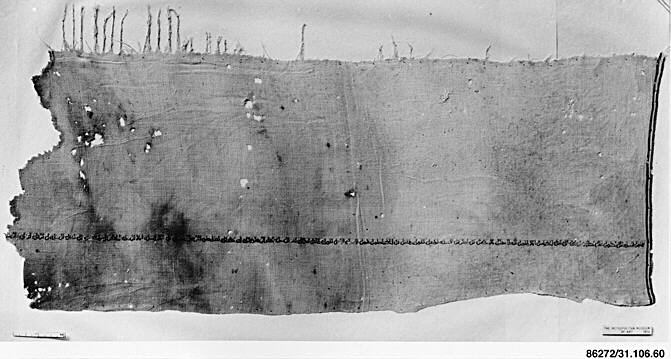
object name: textile fragment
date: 1001-1100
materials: linen, silk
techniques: weave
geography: egypt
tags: arabic